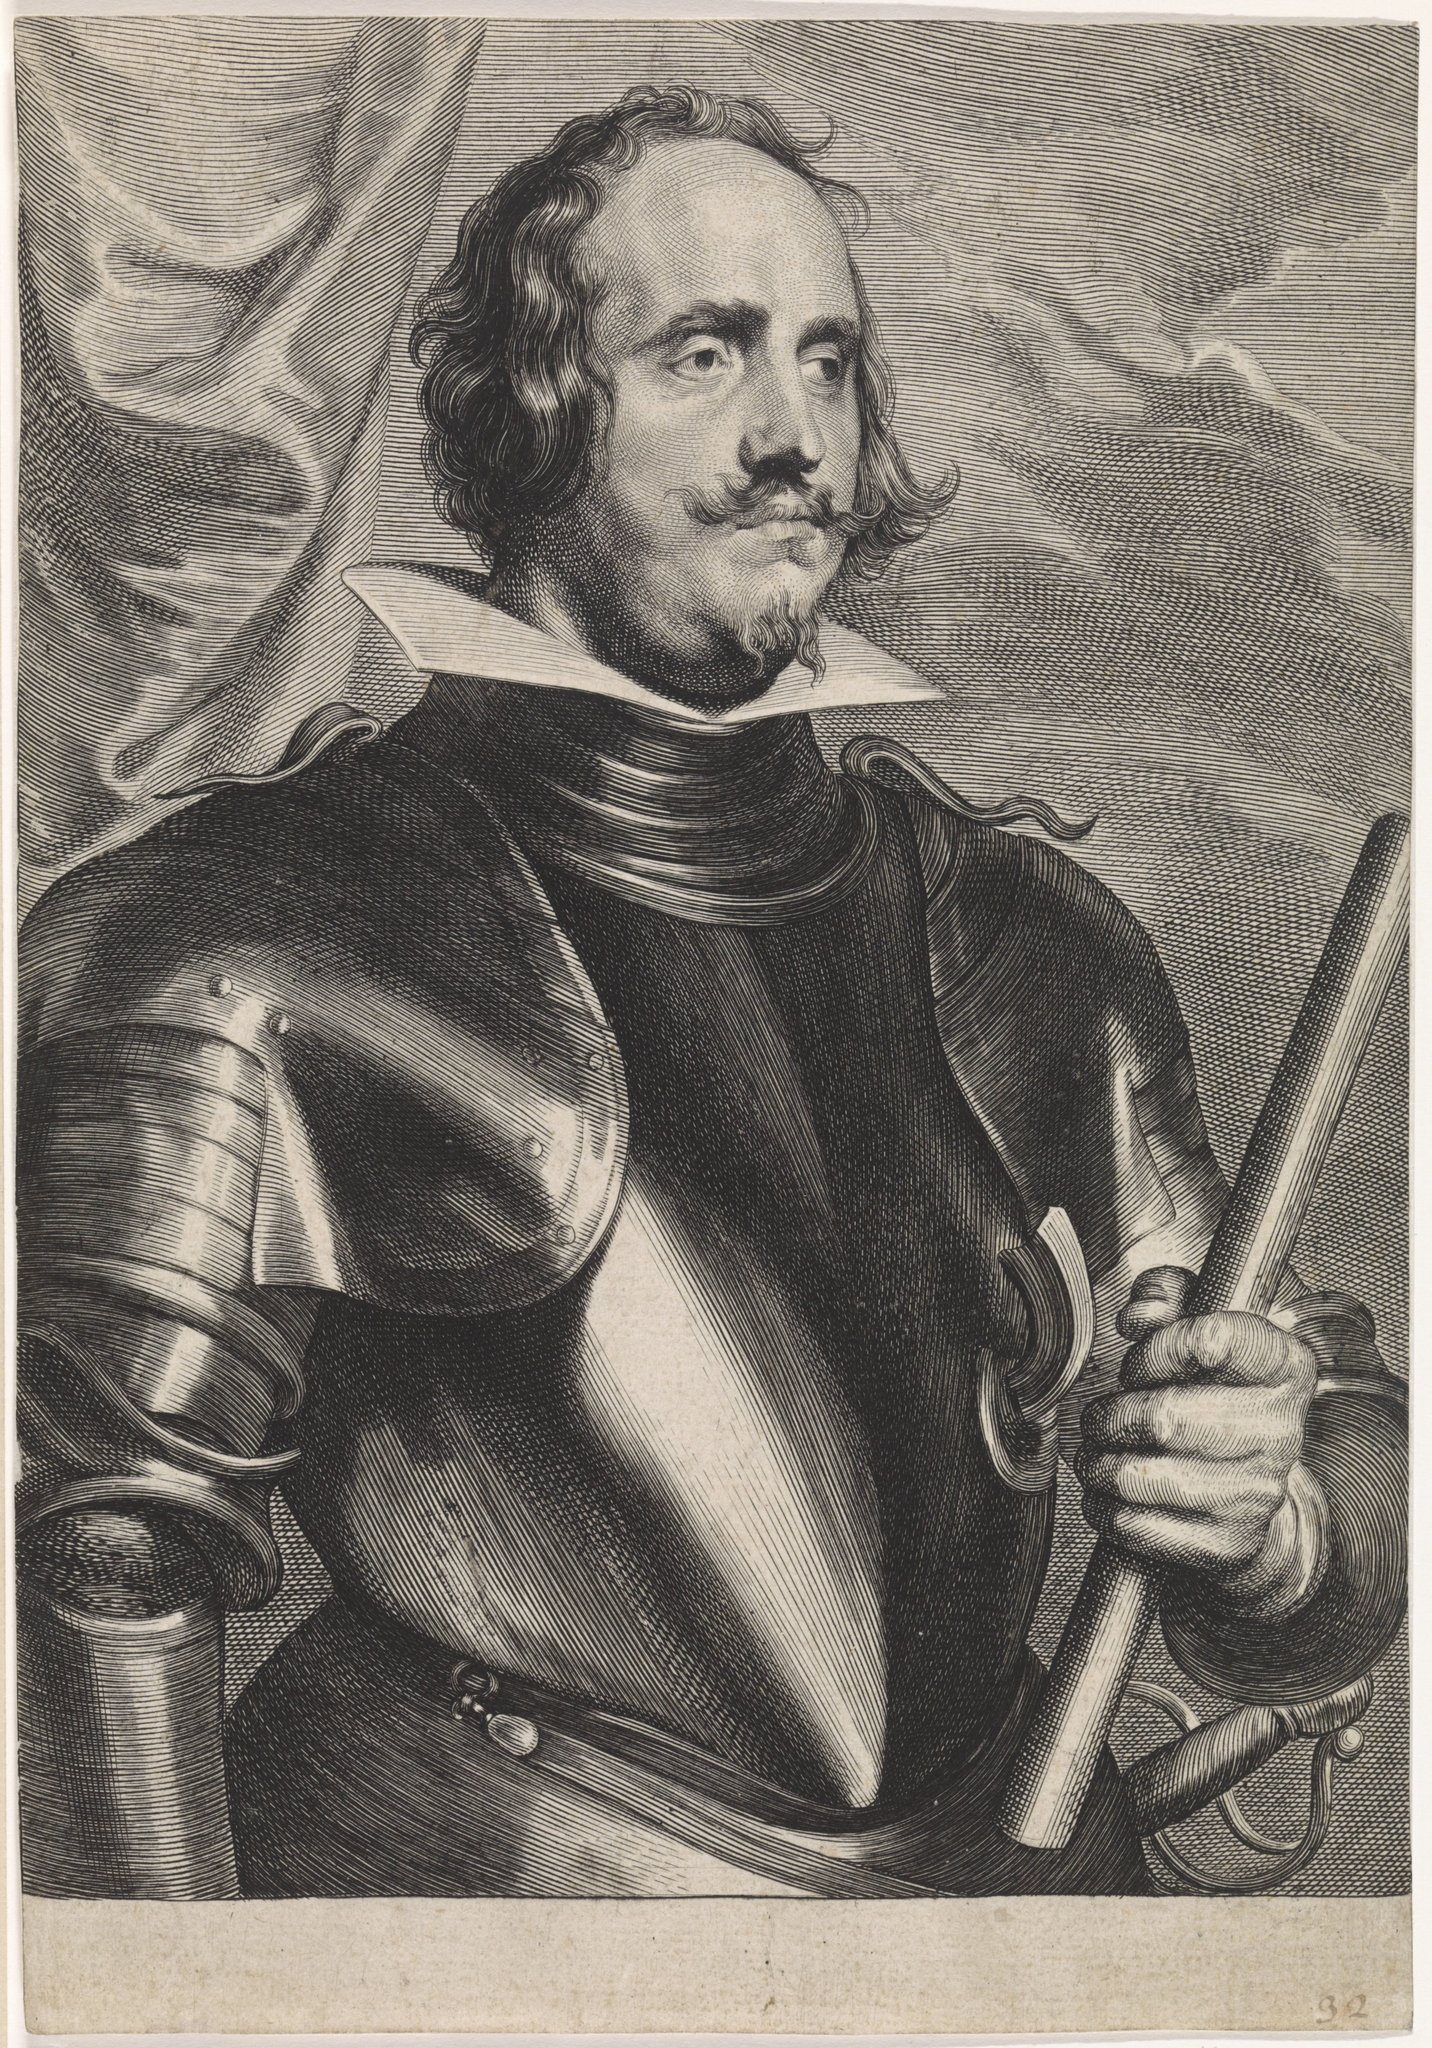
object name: print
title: Portret van Emanuel Frockas, graaf van Feria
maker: paulus pontius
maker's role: draughtsman, print maker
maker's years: 1603-1658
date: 1616-1657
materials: paper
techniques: engraving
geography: antwerp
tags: armour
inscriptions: collector's mark: Lugt 240, number: ‘92’